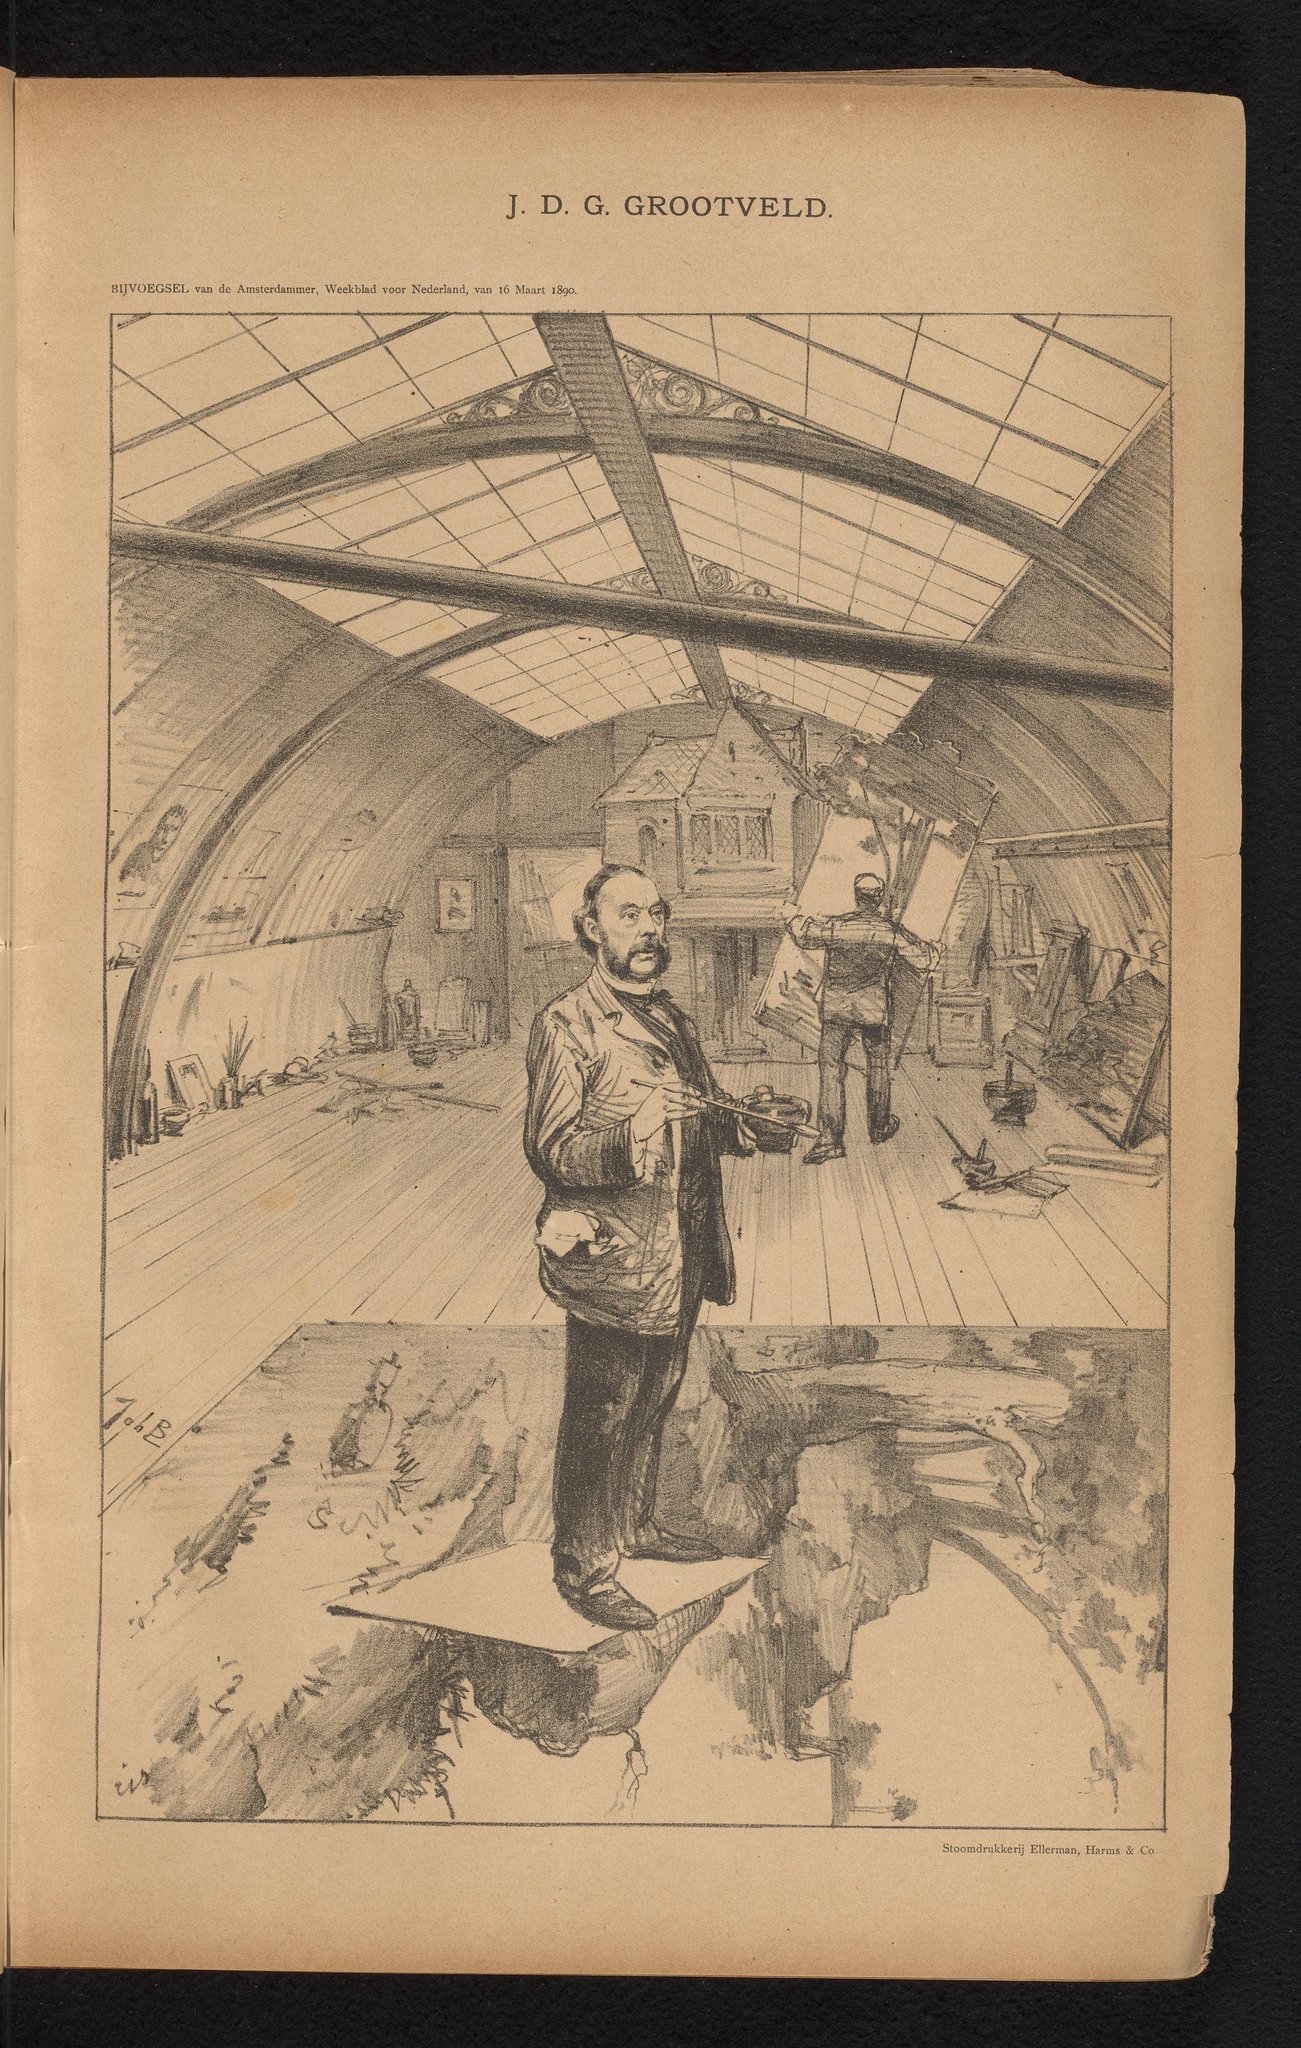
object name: print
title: J.D.G. Grootveld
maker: johan braakensiek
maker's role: draughtsman, print maker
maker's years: 1858-1940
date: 1890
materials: paper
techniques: lithograph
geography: amsterdam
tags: painter, historical persons, portrait, self-portrait of painter, painter at work, in his studio, portrait, self-portrait of artist, amsterdam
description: De schilder en chef-decorateur in het Paleis voor Volksvlijt te Amsterdam, Jan David Geerling Grootveld, aan het werk in zijn atelier. Bij zijn overlijden op 25 februari 1890.